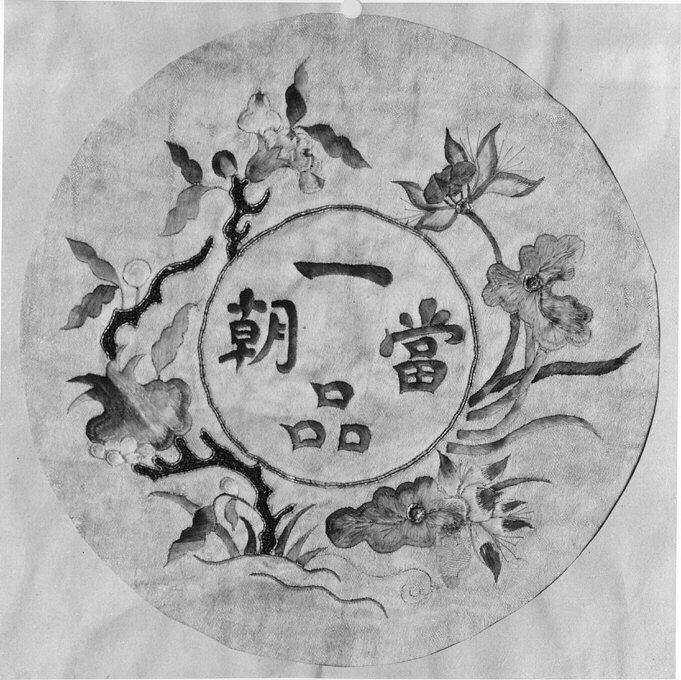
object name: medallion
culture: chinese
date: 1801-1900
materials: metal thread, silk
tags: flowers